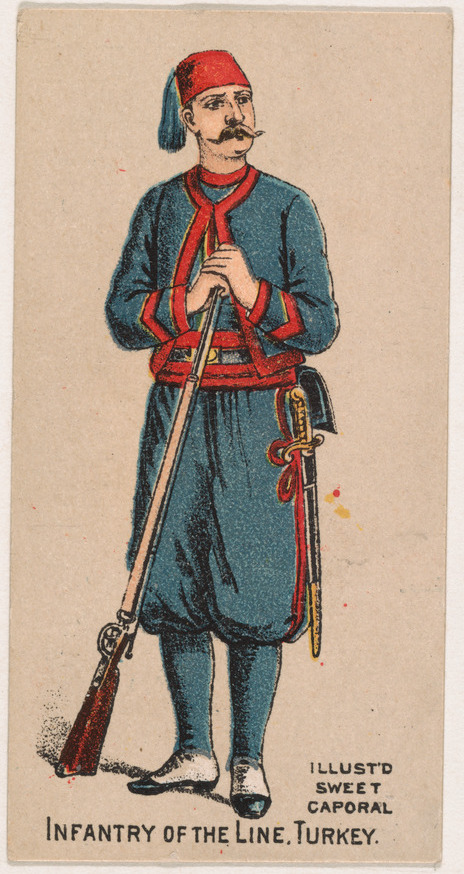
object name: print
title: Infantry of the Line, Turkey, from the Military Series (N224) issued by Kinney Tobacco Company to promote Sweet Caporal Cigarettes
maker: kinney brothers tobacco company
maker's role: publisher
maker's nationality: american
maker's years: 1869-2011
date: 1888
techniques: color lithograph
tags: military,firearms,swords,men